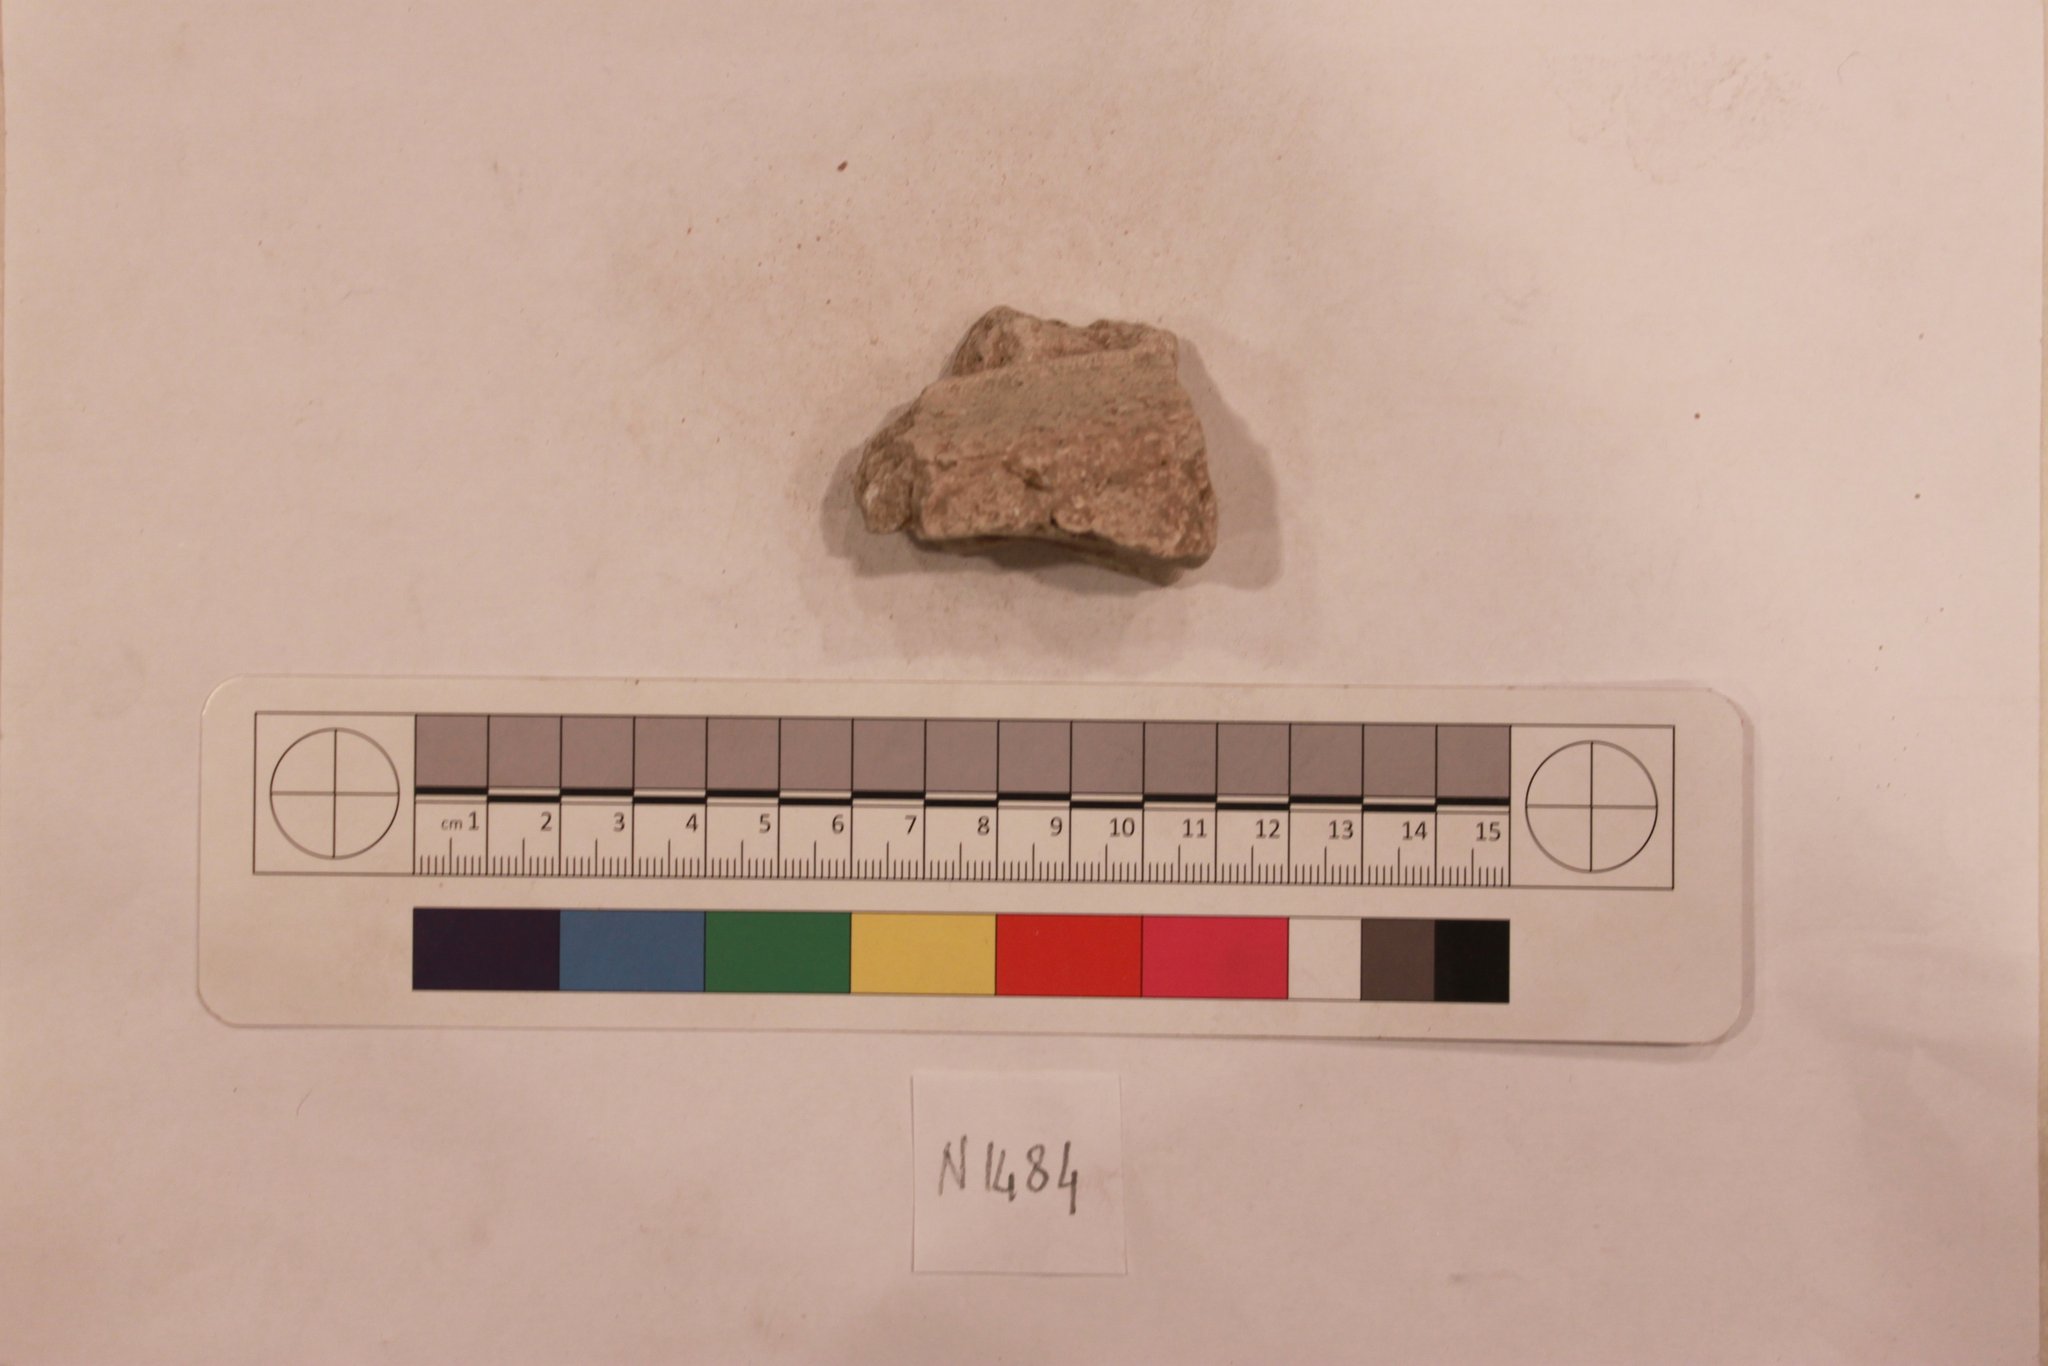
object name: fragment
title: Stucco Fragment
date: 701-1200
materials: plaster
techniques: carving, painting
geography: iran